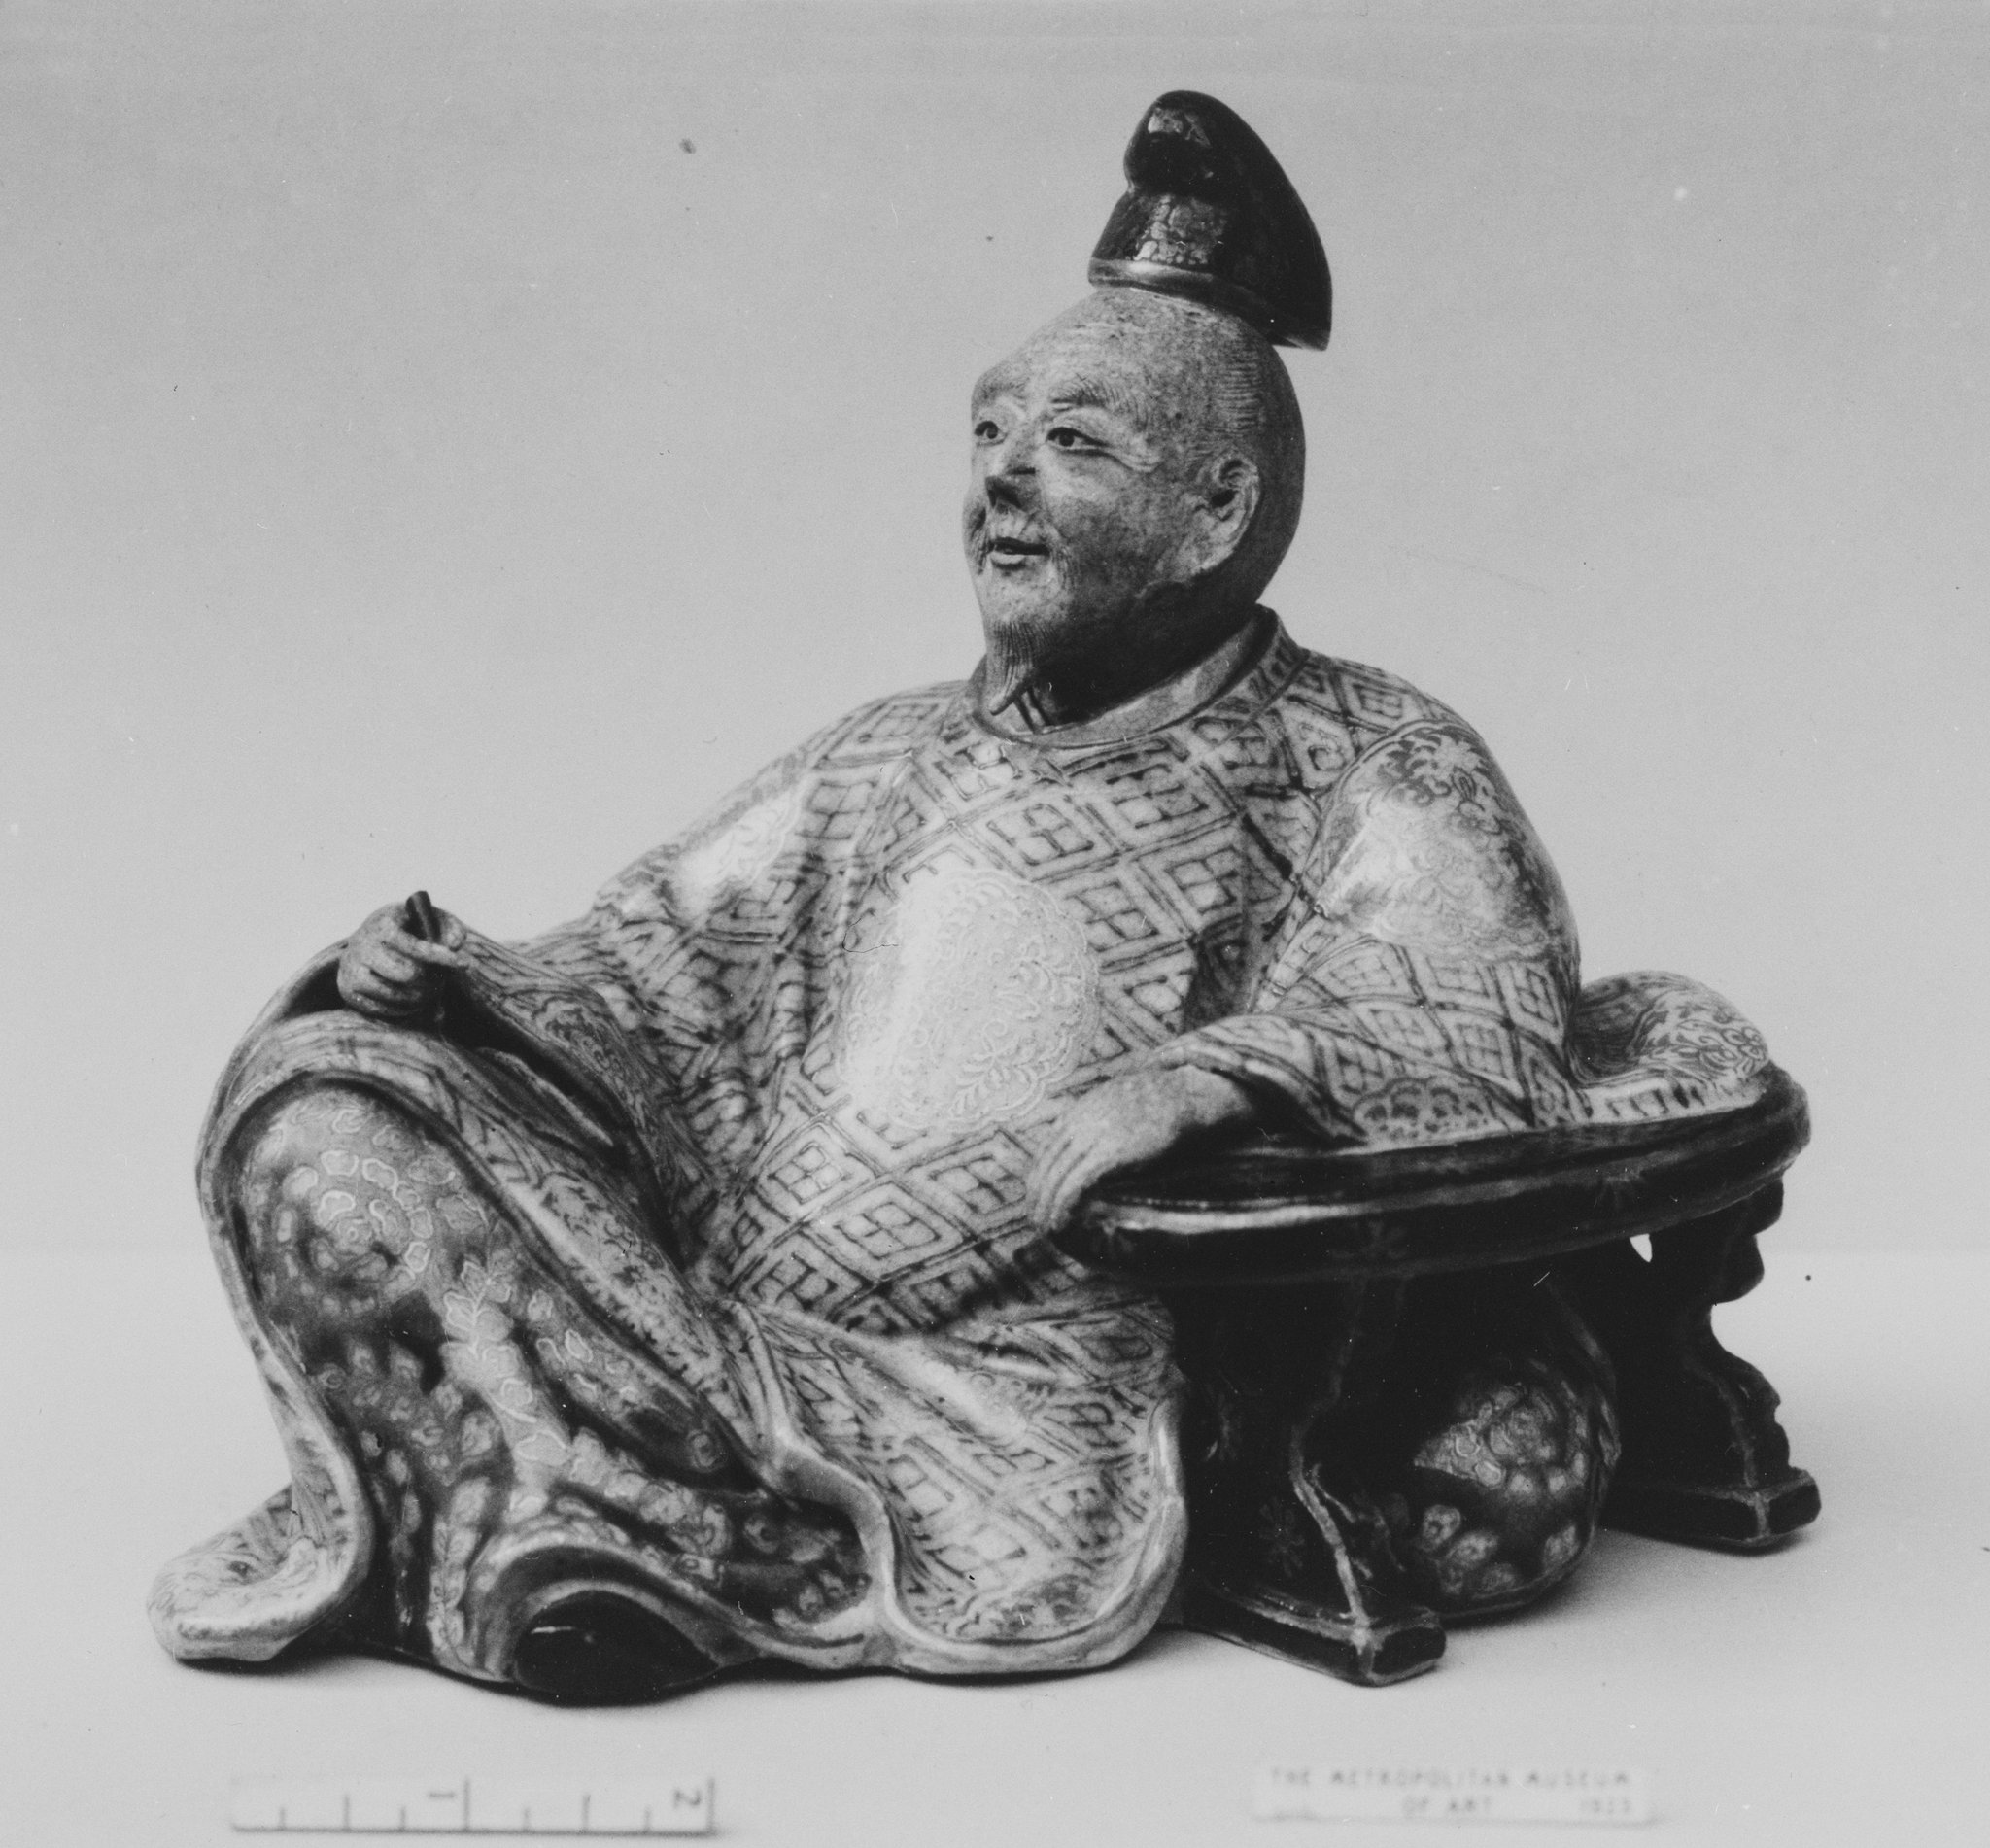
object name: alcove ornament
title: Ornament In form of Poet, Hitomaru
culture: japanese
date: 1720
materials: faience, gold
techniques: polychrome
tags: men,poets